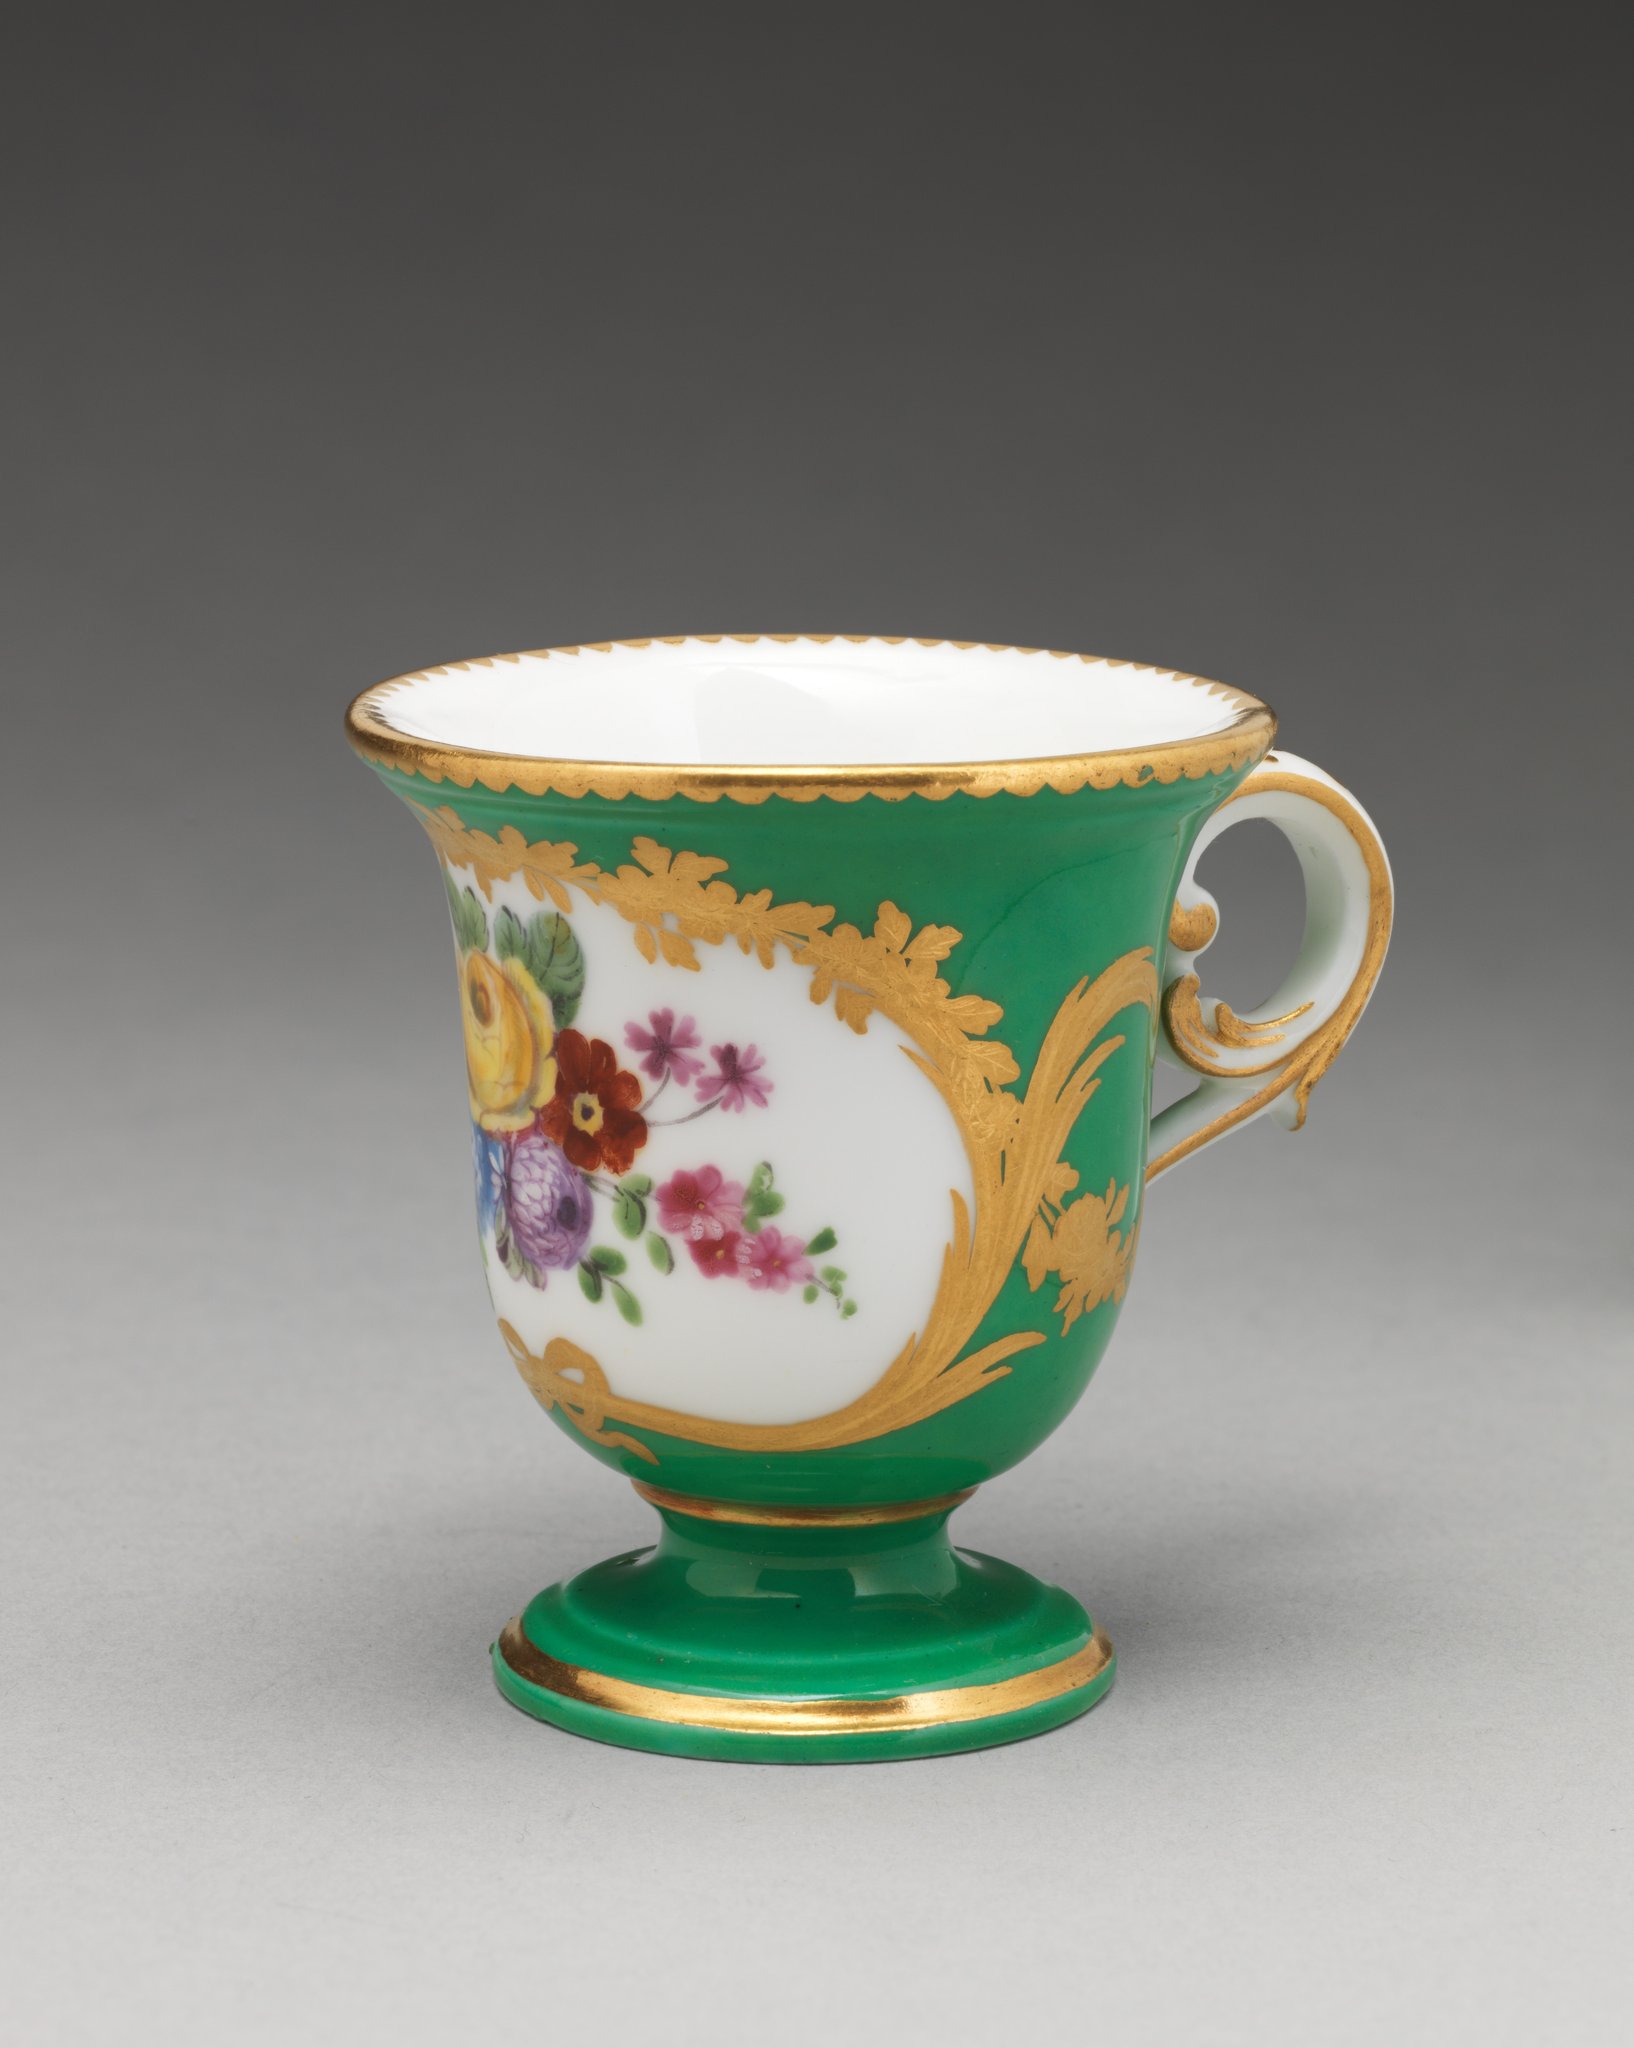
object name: ice cream cup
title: Ice cream cup (Tasse à glace) (part of a service)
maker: sèvres manufactory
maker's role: manufactory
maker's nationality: french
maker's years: 1740-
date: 1771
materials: soft paste porcelain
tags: flowers